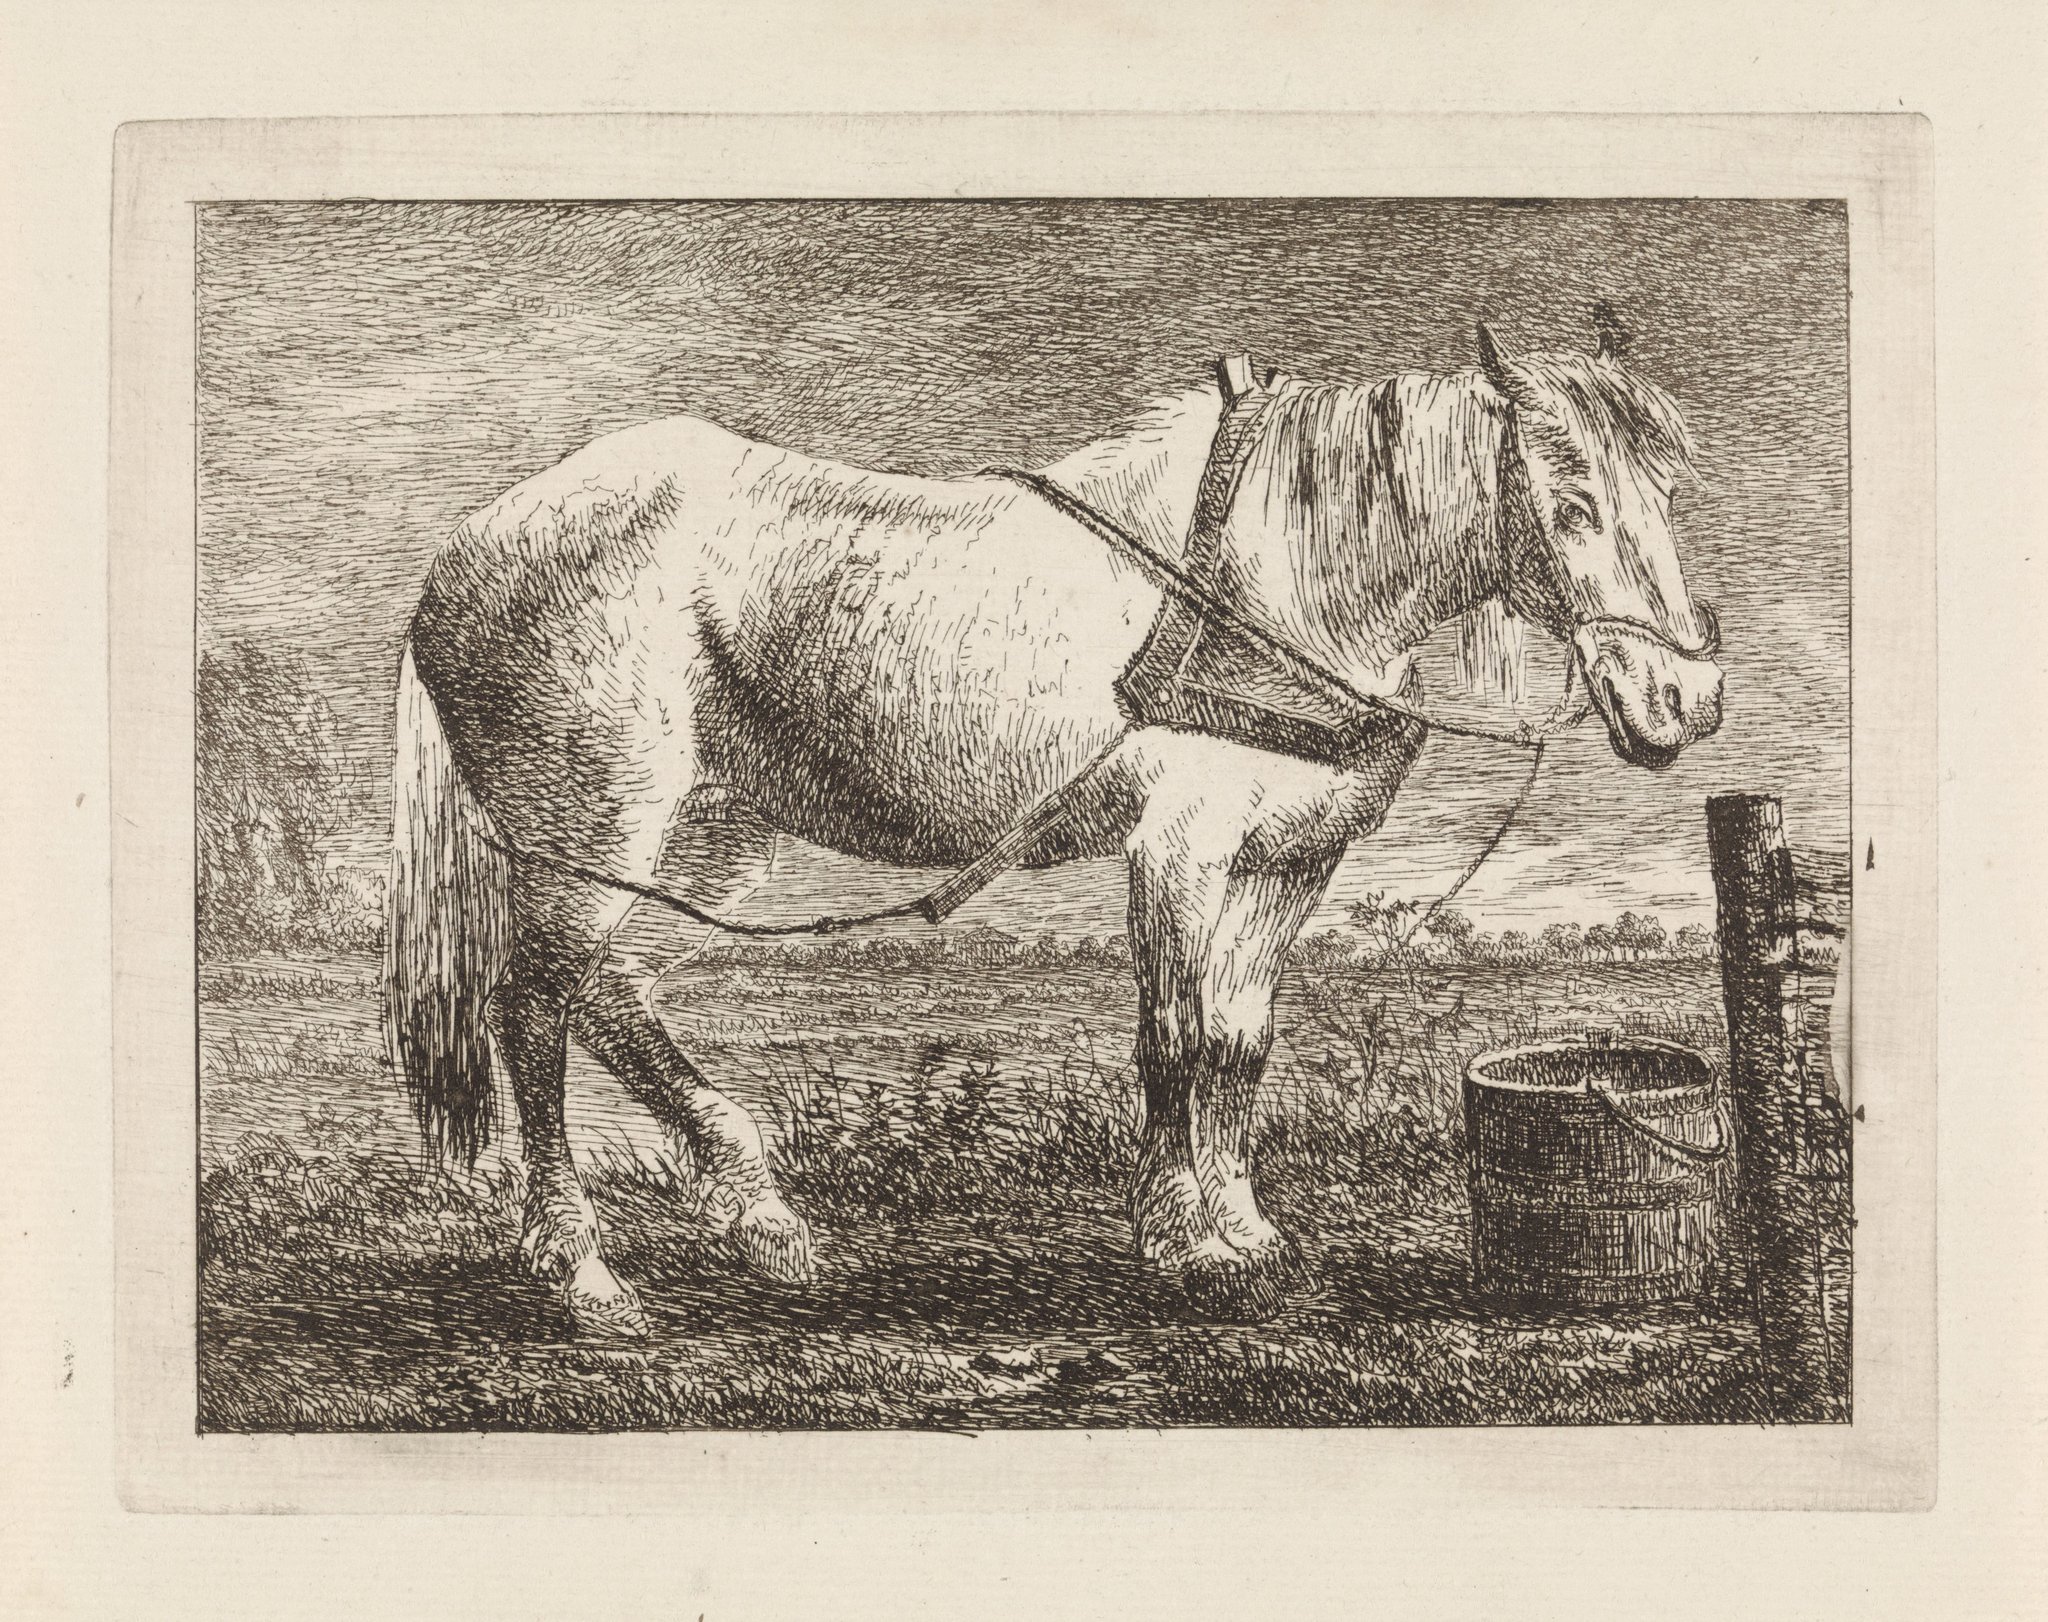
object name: print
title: Paard bij een emmer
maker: gerard van nijmegen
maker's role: draughtsman, painter, print maker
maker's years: 1735-1808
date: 1745-1808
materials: paper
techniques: etching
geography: rotterdam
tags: horses and kindred animals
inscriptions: collector's mark: Lugt 2228